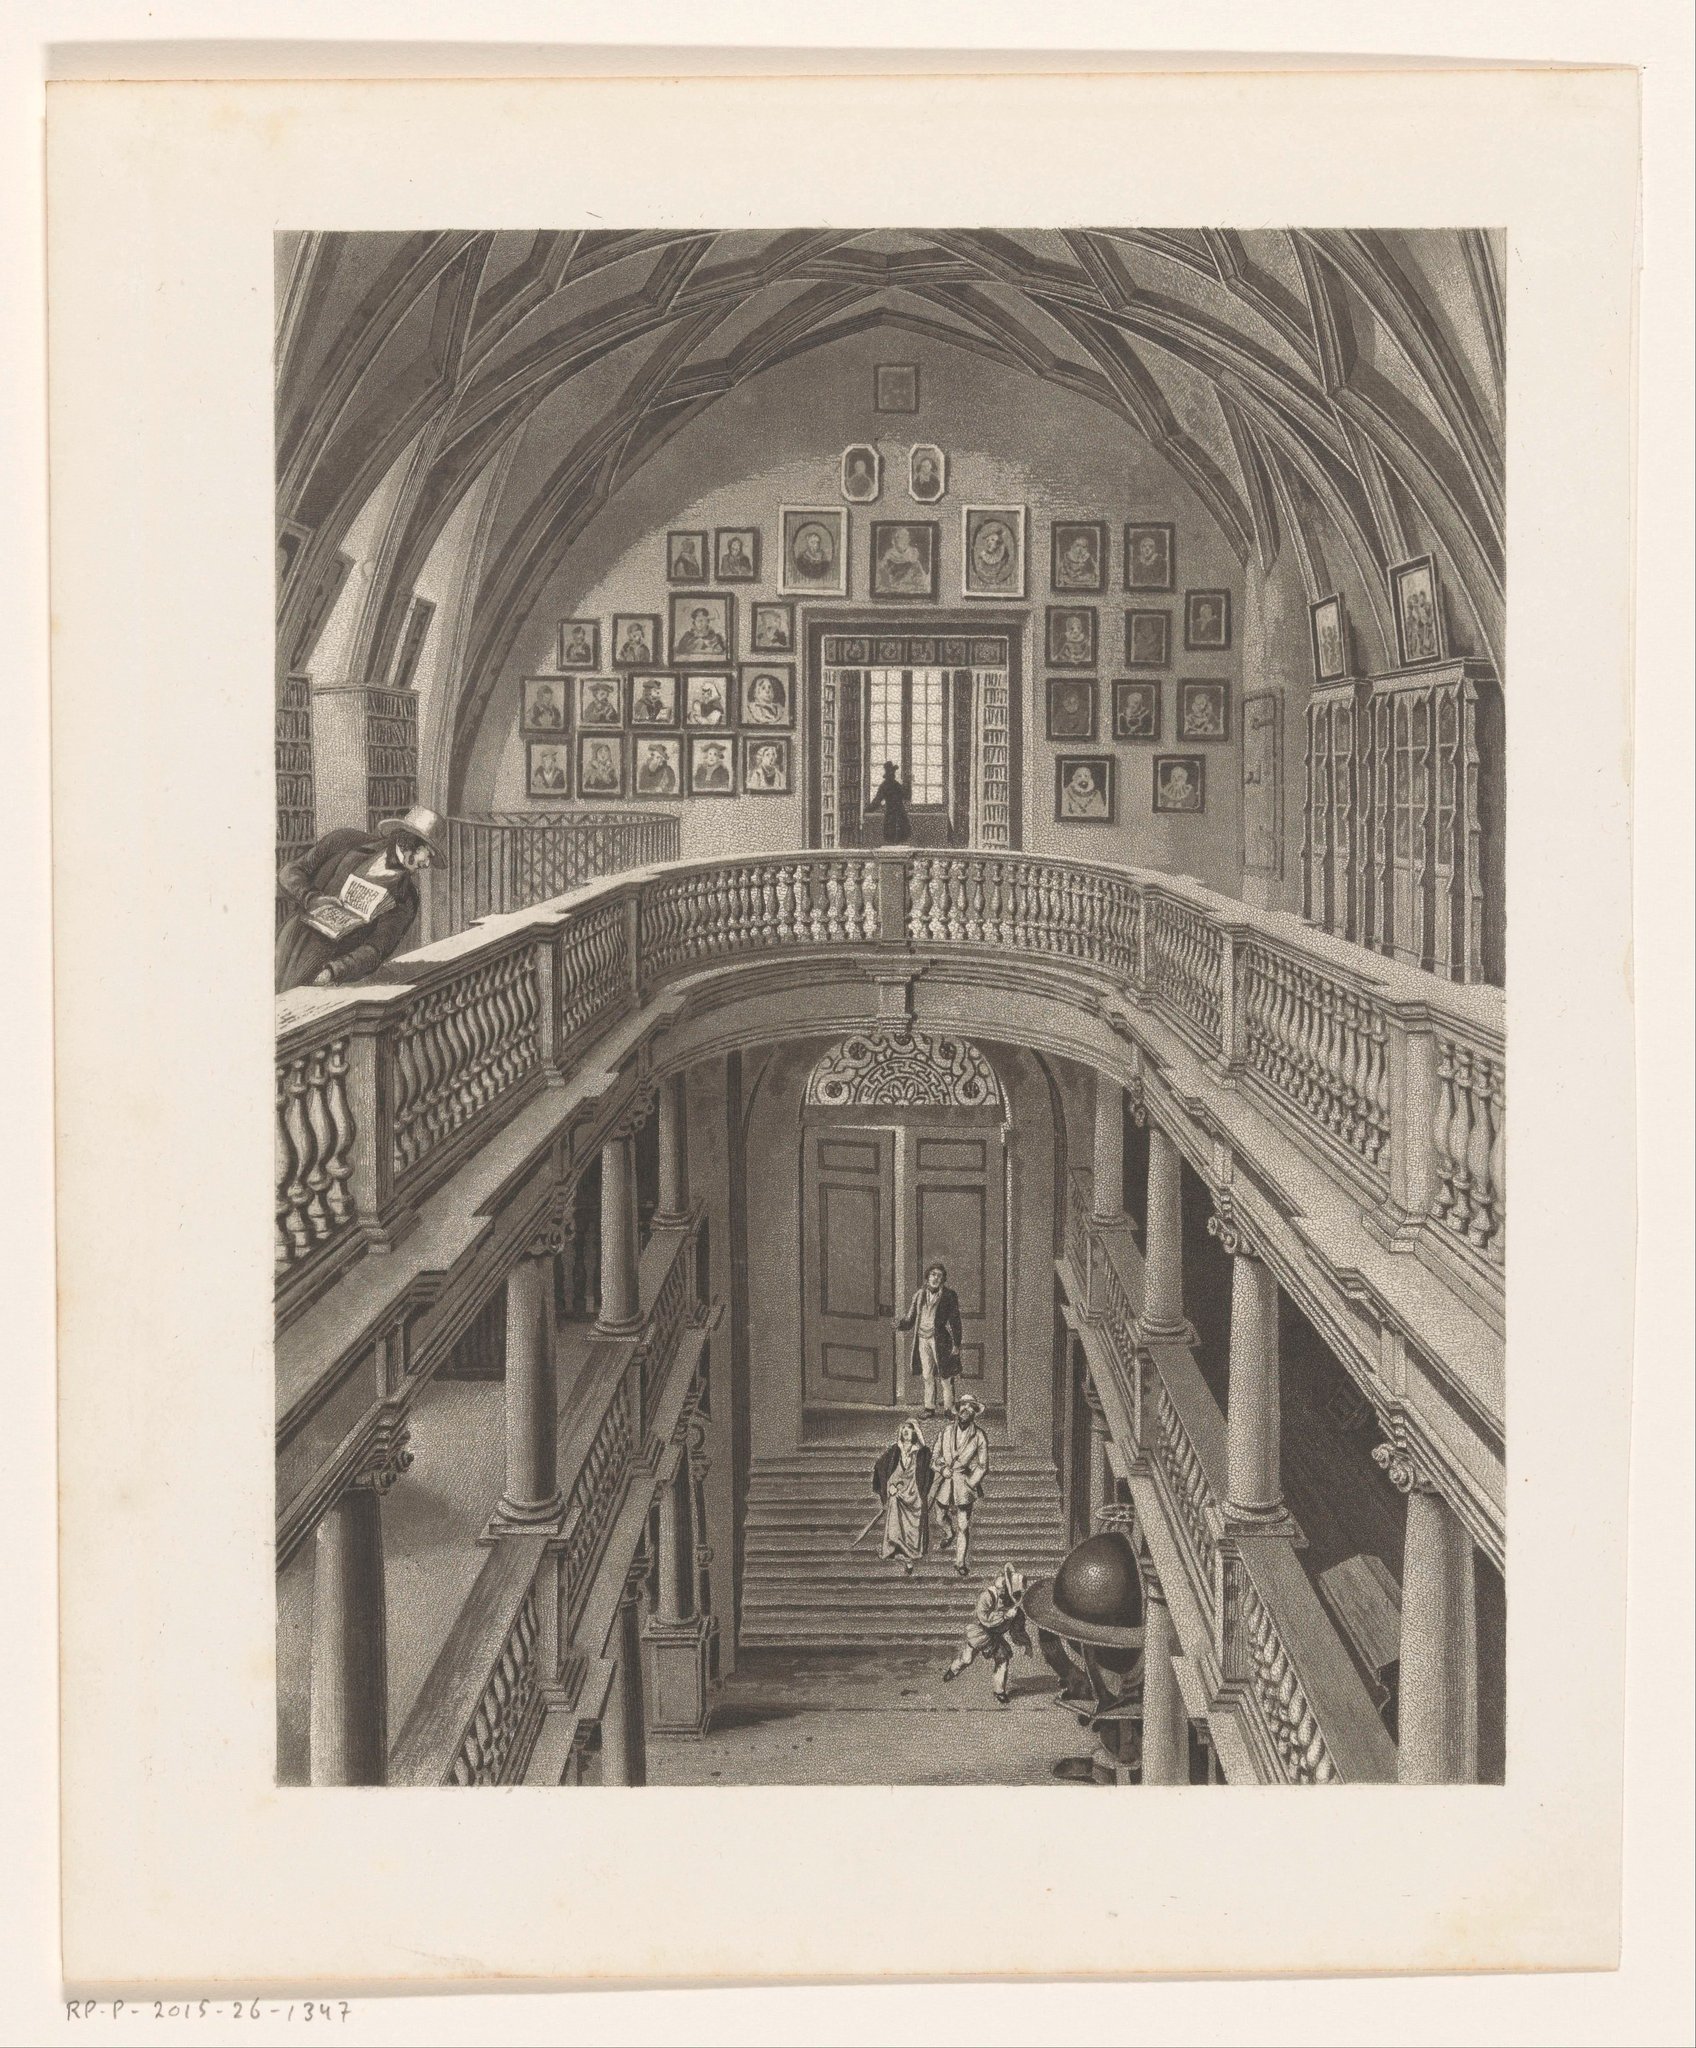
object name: print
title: Interieur van de Wasserkirche te Zürich, 1847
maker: franz hegi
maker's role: draughtsman, painter, print maker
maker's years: 1774-1850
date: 1848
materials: paper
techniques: aquatint, etching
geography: zurich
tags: picture, painting, globe, public library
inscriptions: collector's mark: Lugt 2228, collector's mark: Lugt 4780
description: Gezicht vanaf de bovenste verdieping van de Wasserkirche. Een man met een boek in zijn hand kijkt over de balustrade naar een gezin dat beneden loopt. Tegen de muur van de bovenste verdieping hangt een portrettenverzameling; op de begane grond staat een globe.